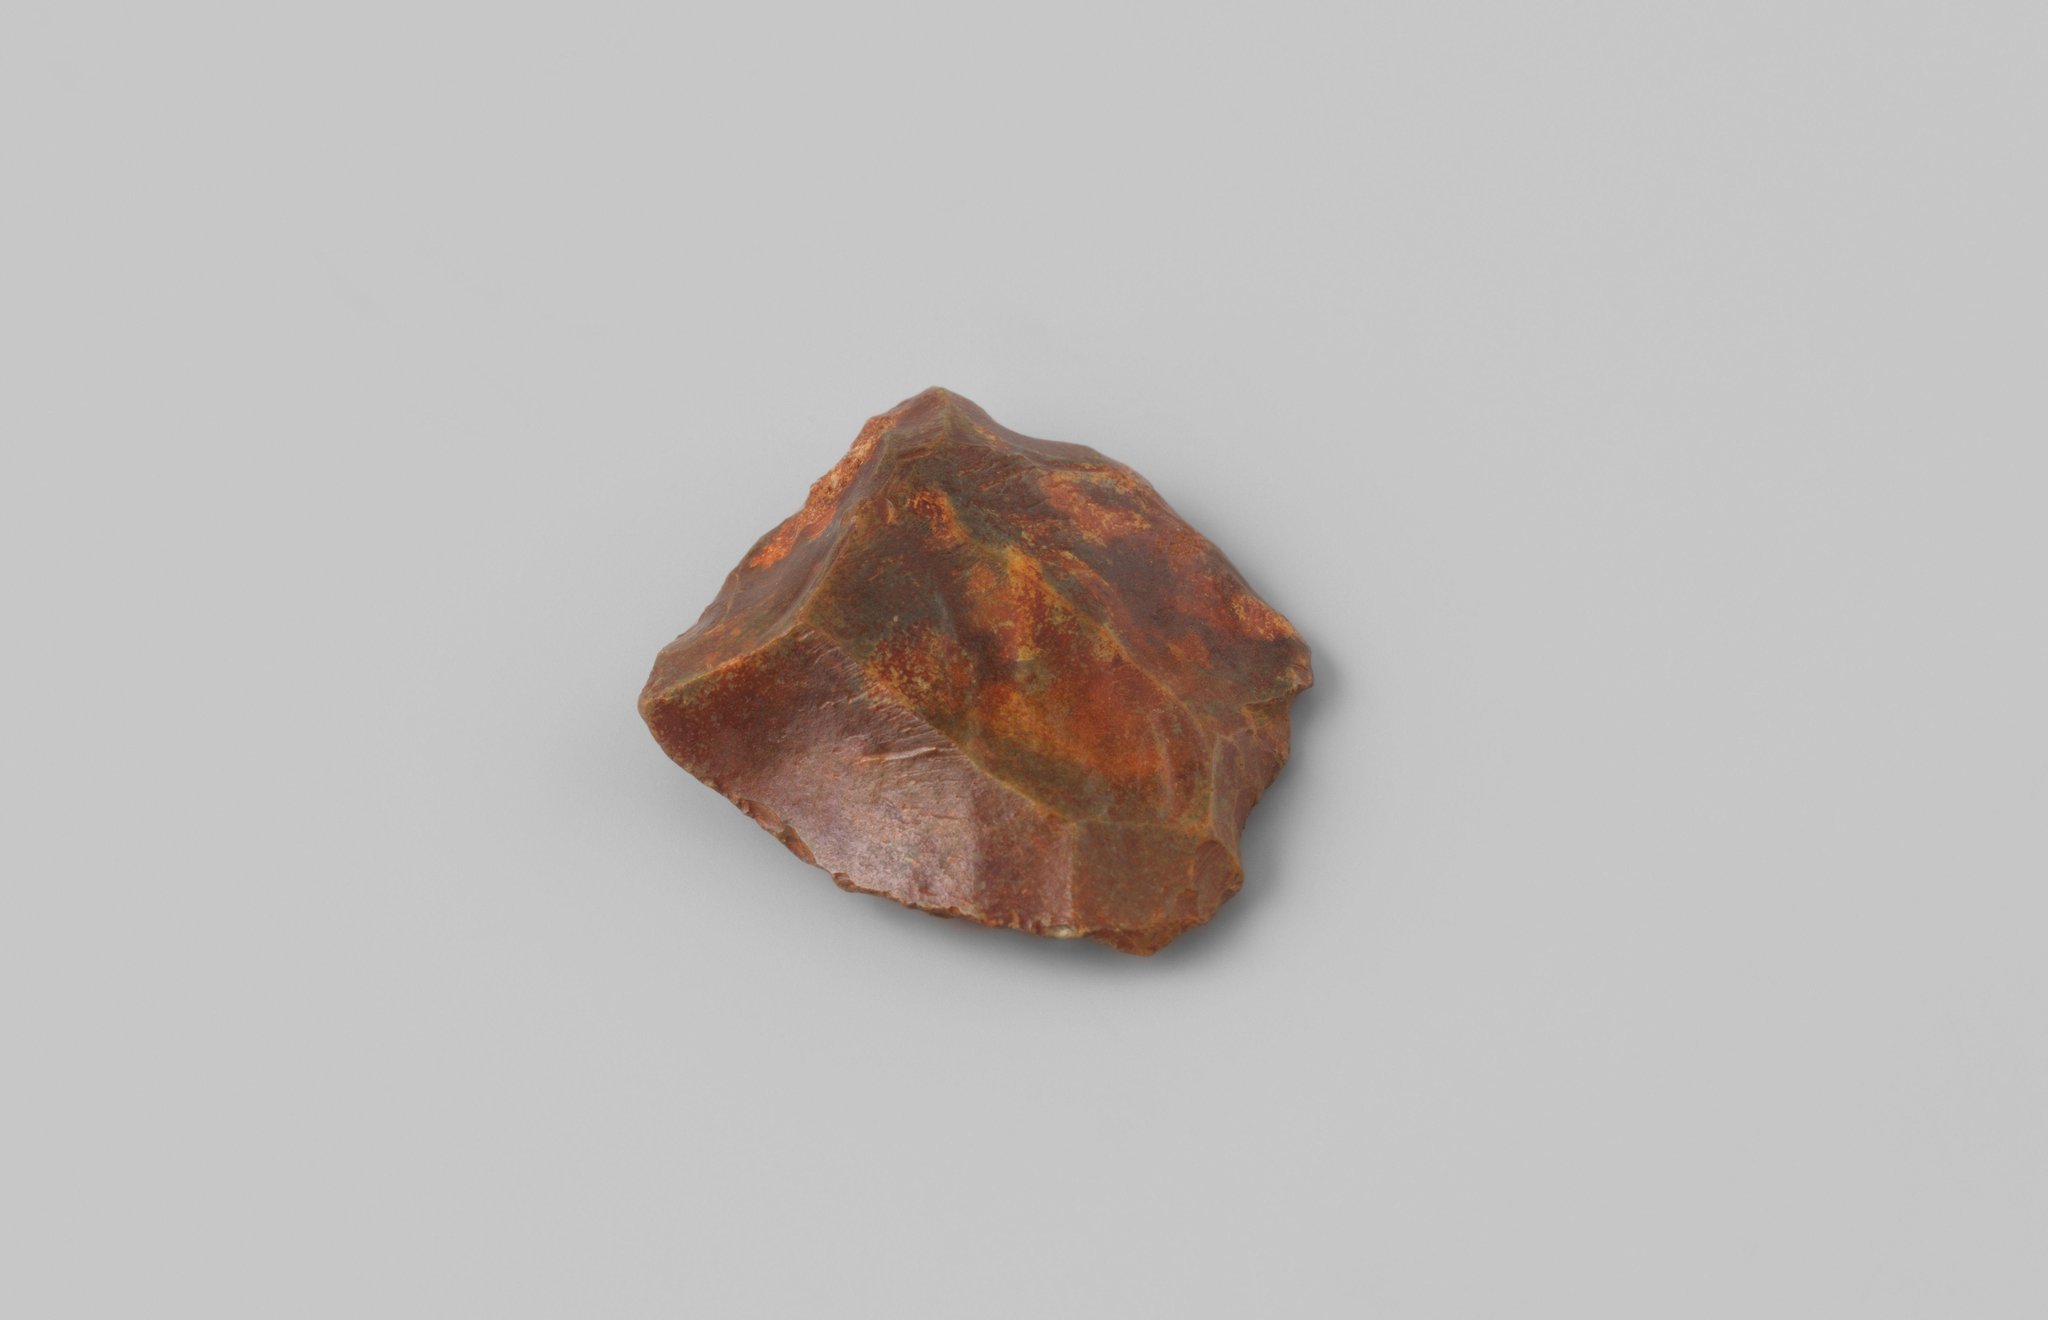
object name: gunflint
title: Vuursteen van een handwapen uit het wrak van de Oost-Indiëvaarder Hollandia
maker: Anonymous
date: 1700-1743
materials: stone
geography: netherlands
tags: verenigde oostindische compagnie, hollandia (schip), annet